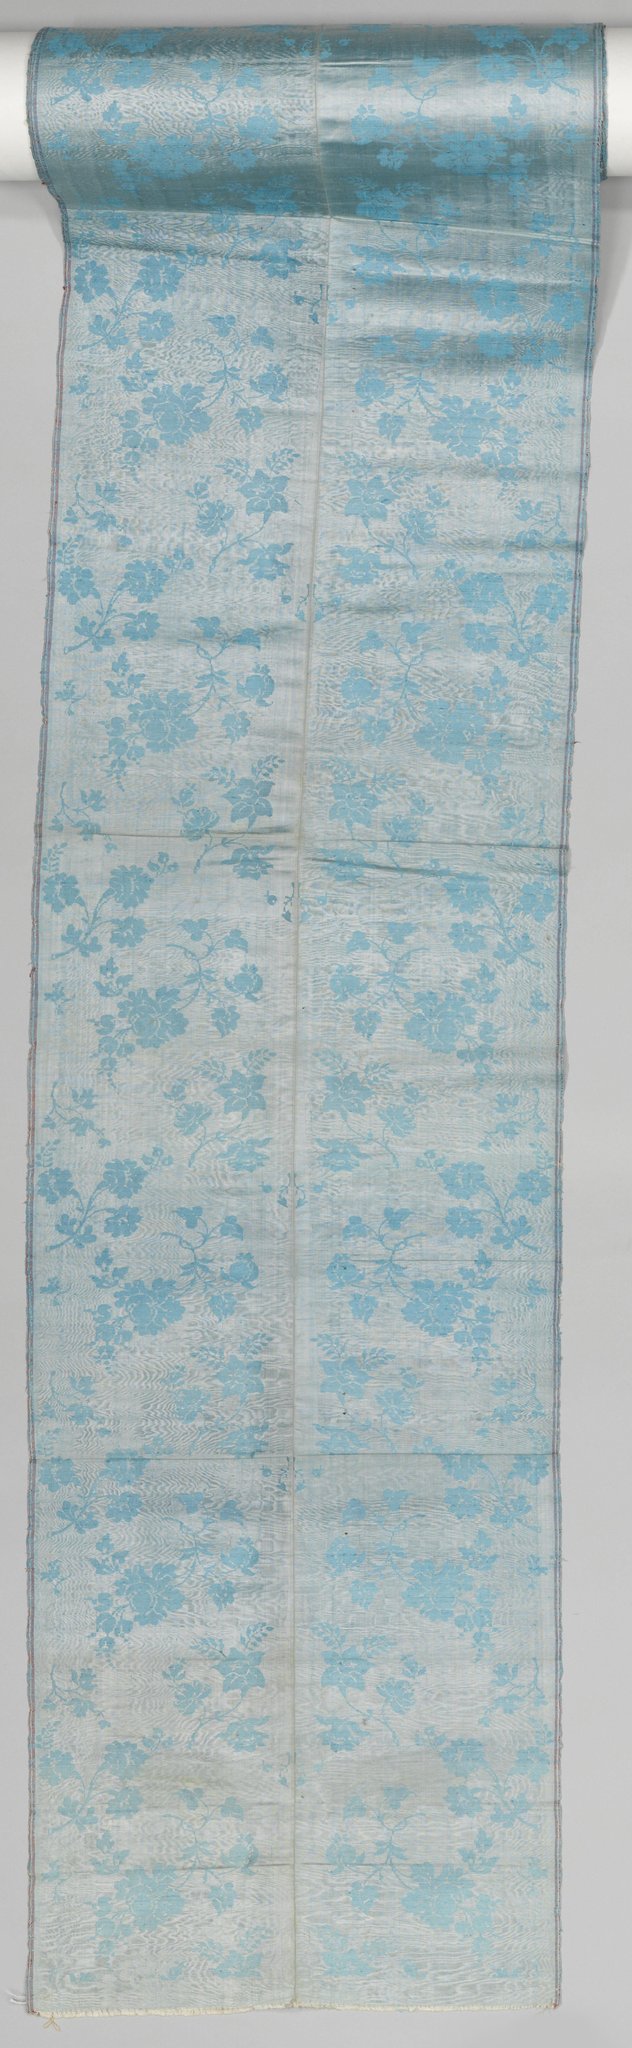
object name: zijdedamast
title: Fragment blauw zijdeweefsel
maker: Anonymous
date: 1765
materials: silk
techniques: moire, weave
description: Fragment blauw zijdeweefsel met een patroon van gestrooide bloemtakken.